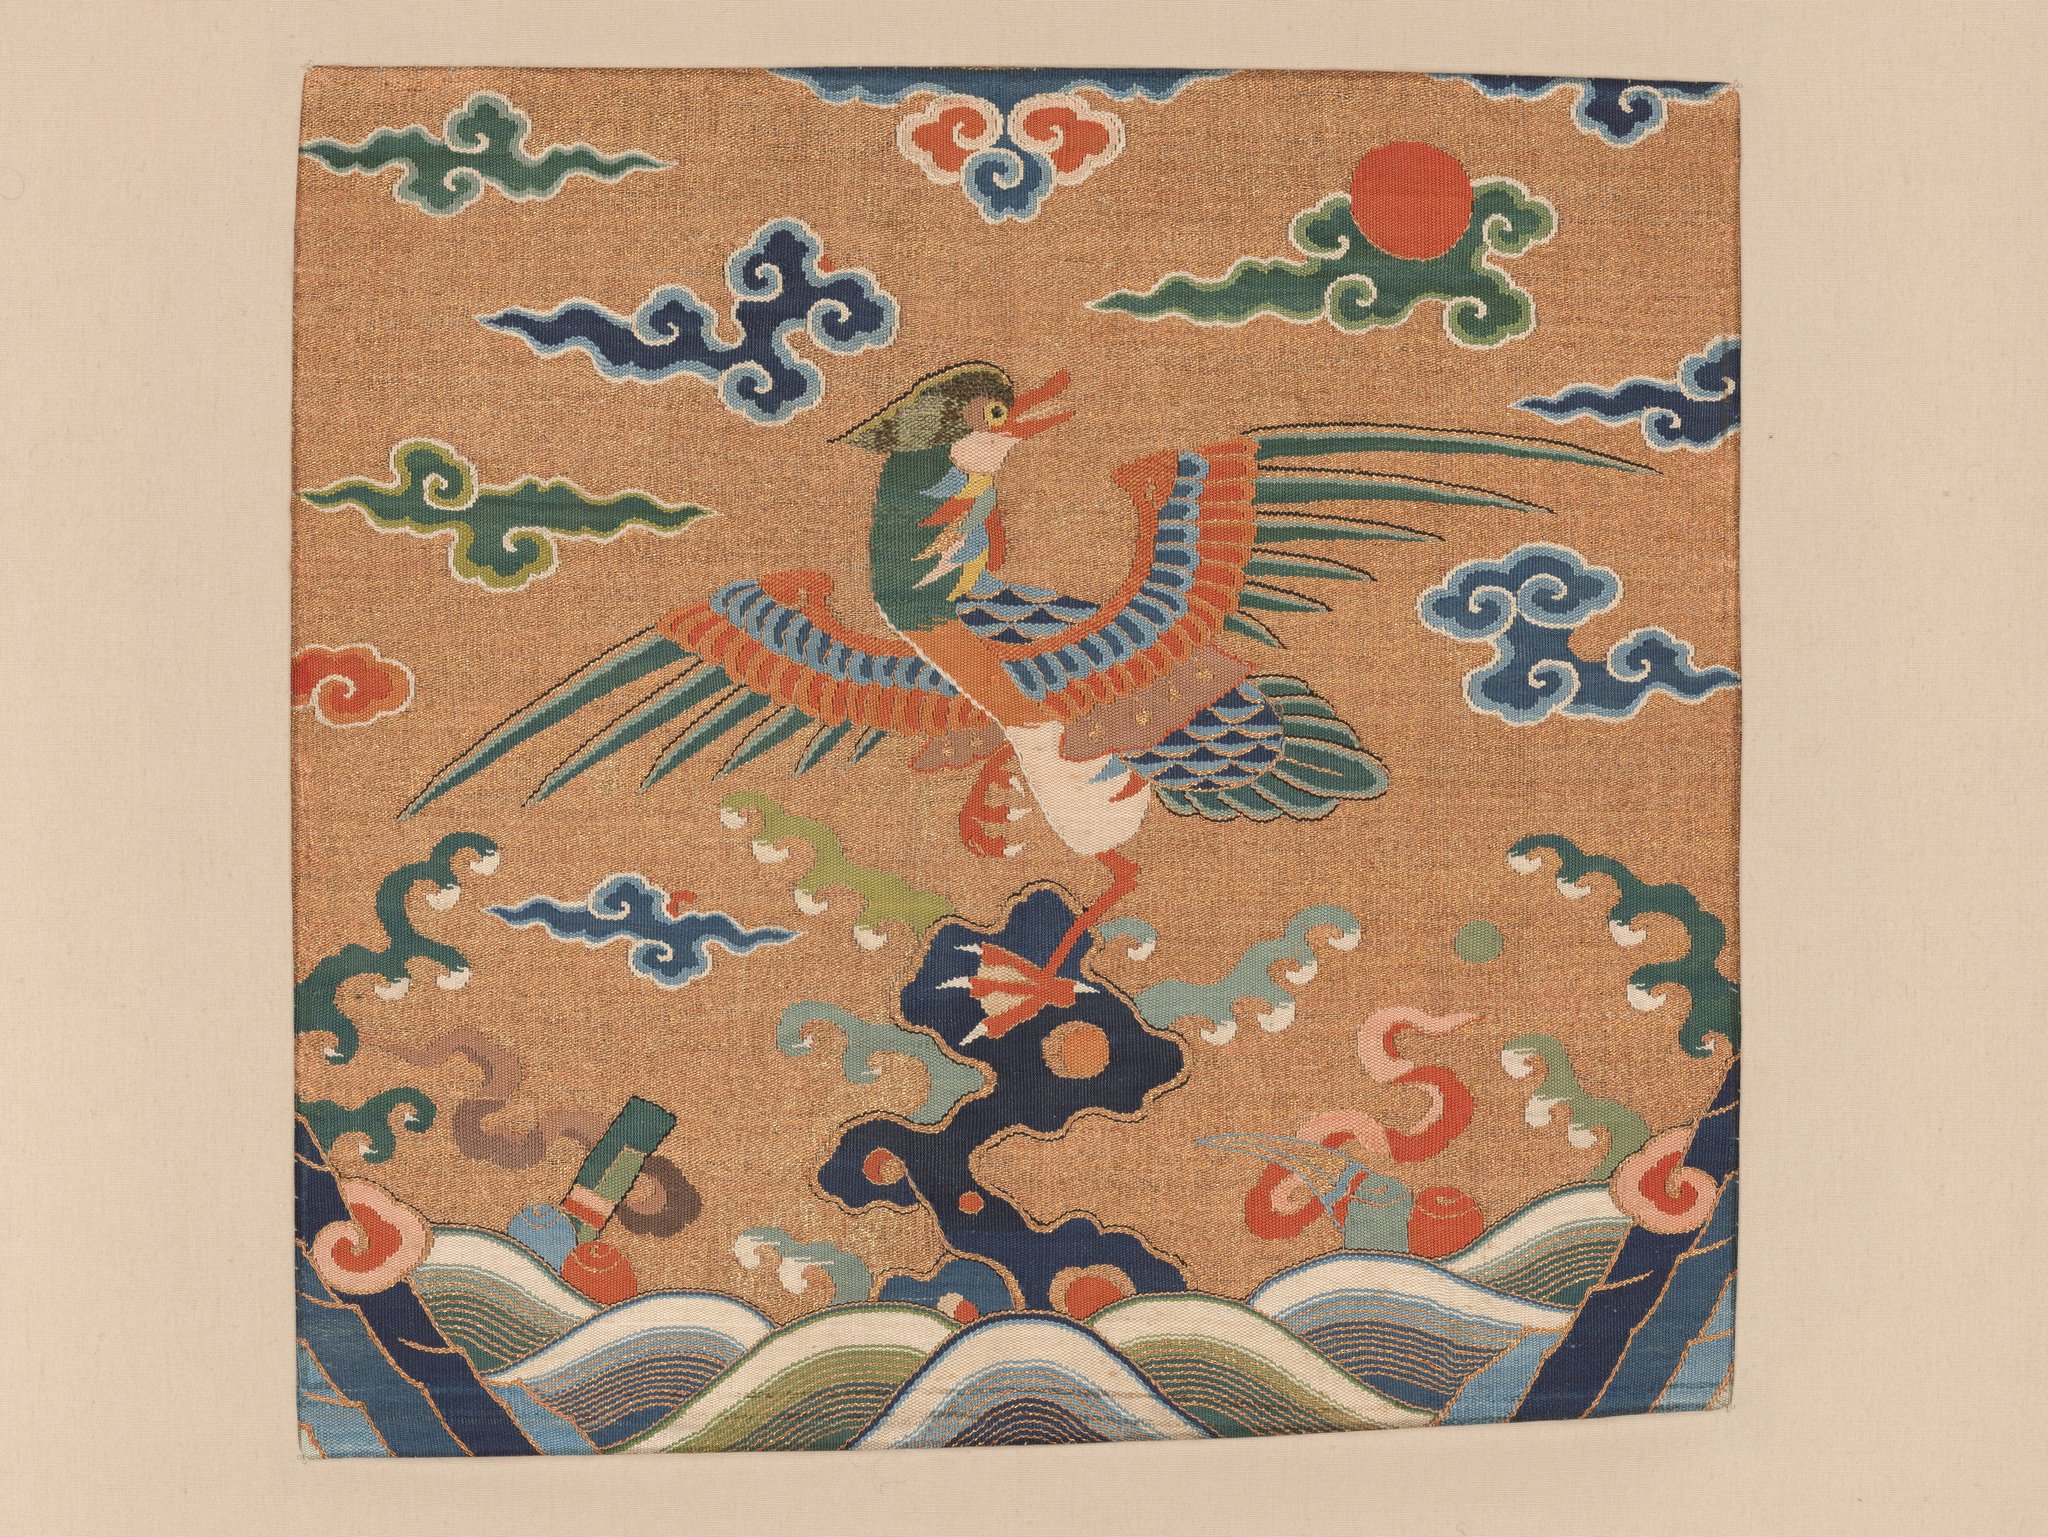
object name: rank badge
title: Rank Badge with Mandarin Duck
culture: chinese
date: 1667-1733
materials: metal thread, silk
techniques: tapestry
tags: ducks